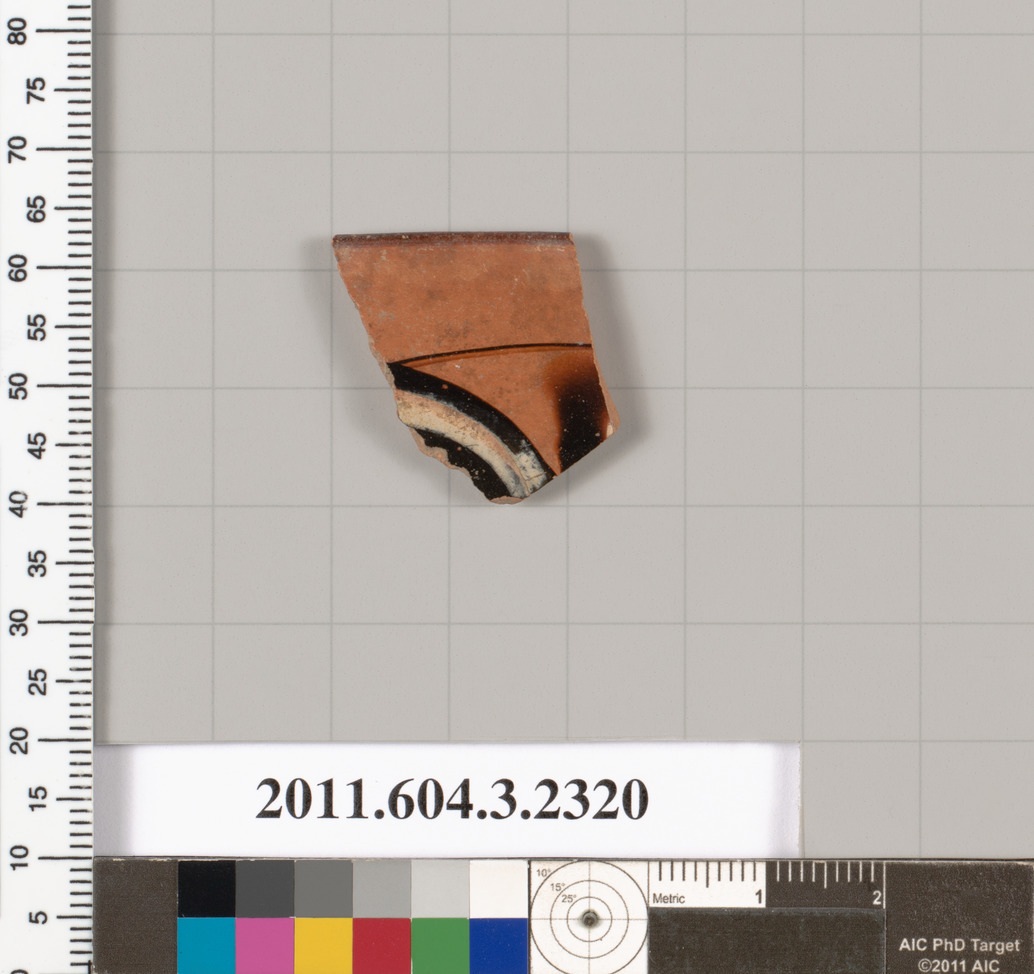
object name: kylix fragment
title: Terracotta rim fragment of a kylix: eye-cup (drinking cup)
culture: greek, attic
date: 530-500 BCE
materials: terracotta